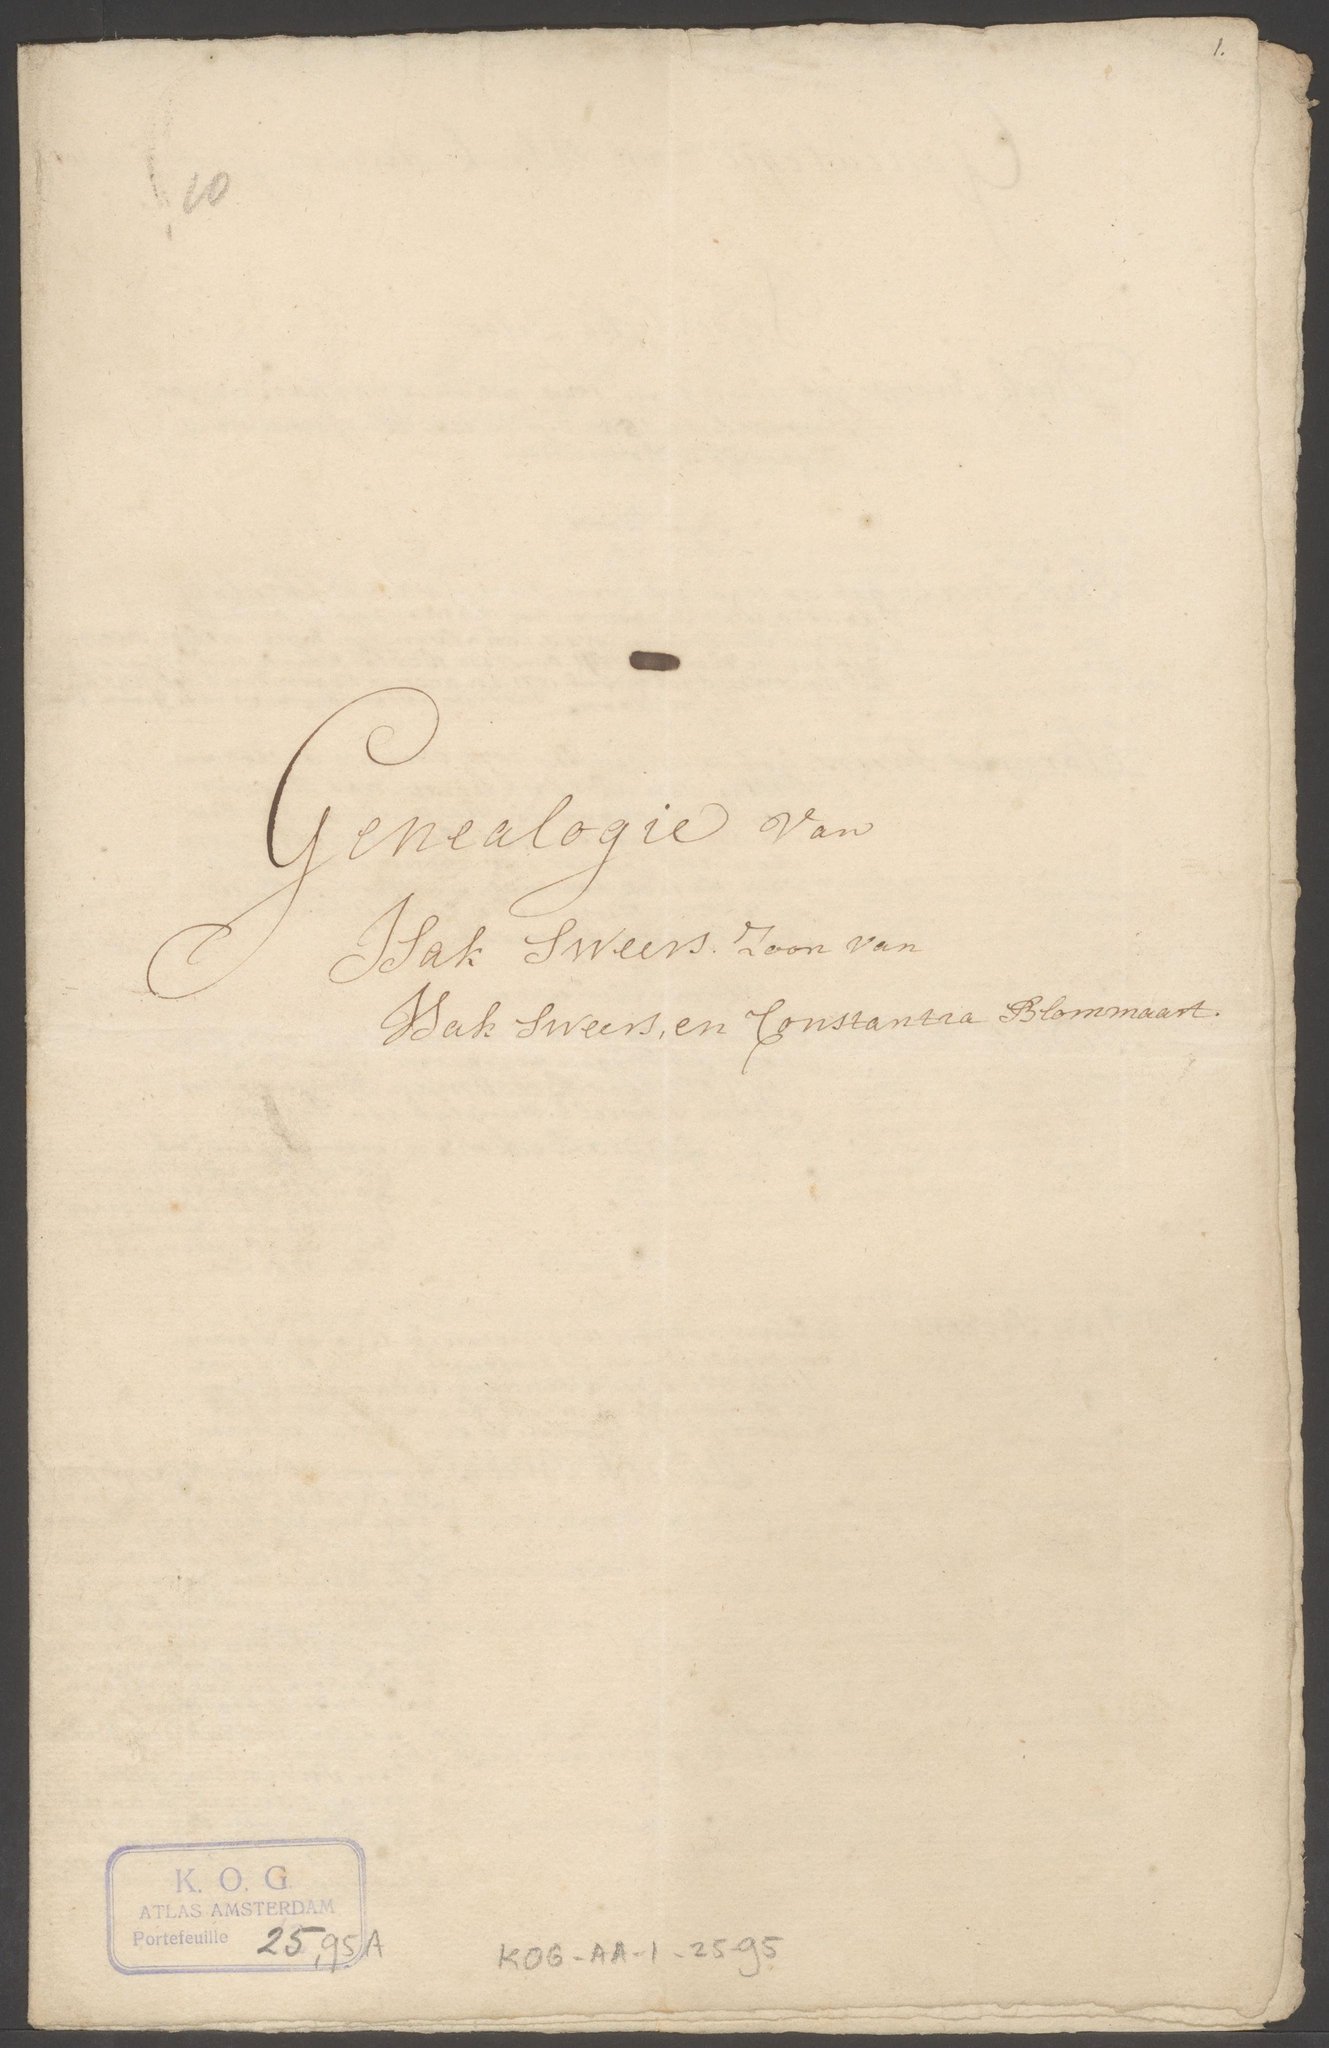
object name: manuscript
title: Genealogie van Isaac Sweers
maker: Anonymous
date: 1777-1799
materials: ink, paper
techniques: pen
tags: amsterdam, family lineage, pedigree, genealogical tree or table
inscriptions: collector's mark: ‘25.95’ Lugt 1641b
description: Handgeschreven genealogie van Isaac Sweers (1671-1732), bestaande uit vier pagina's, twee in elkaar gevouwen losse bladen. Onderwerpsrubriek binnen de Atlas Amsterdam: Krijgswezen I: De Admiraliteit van Amsterdam, B. Vlootvoogden en schepelingen; Herinneringen daaraan.